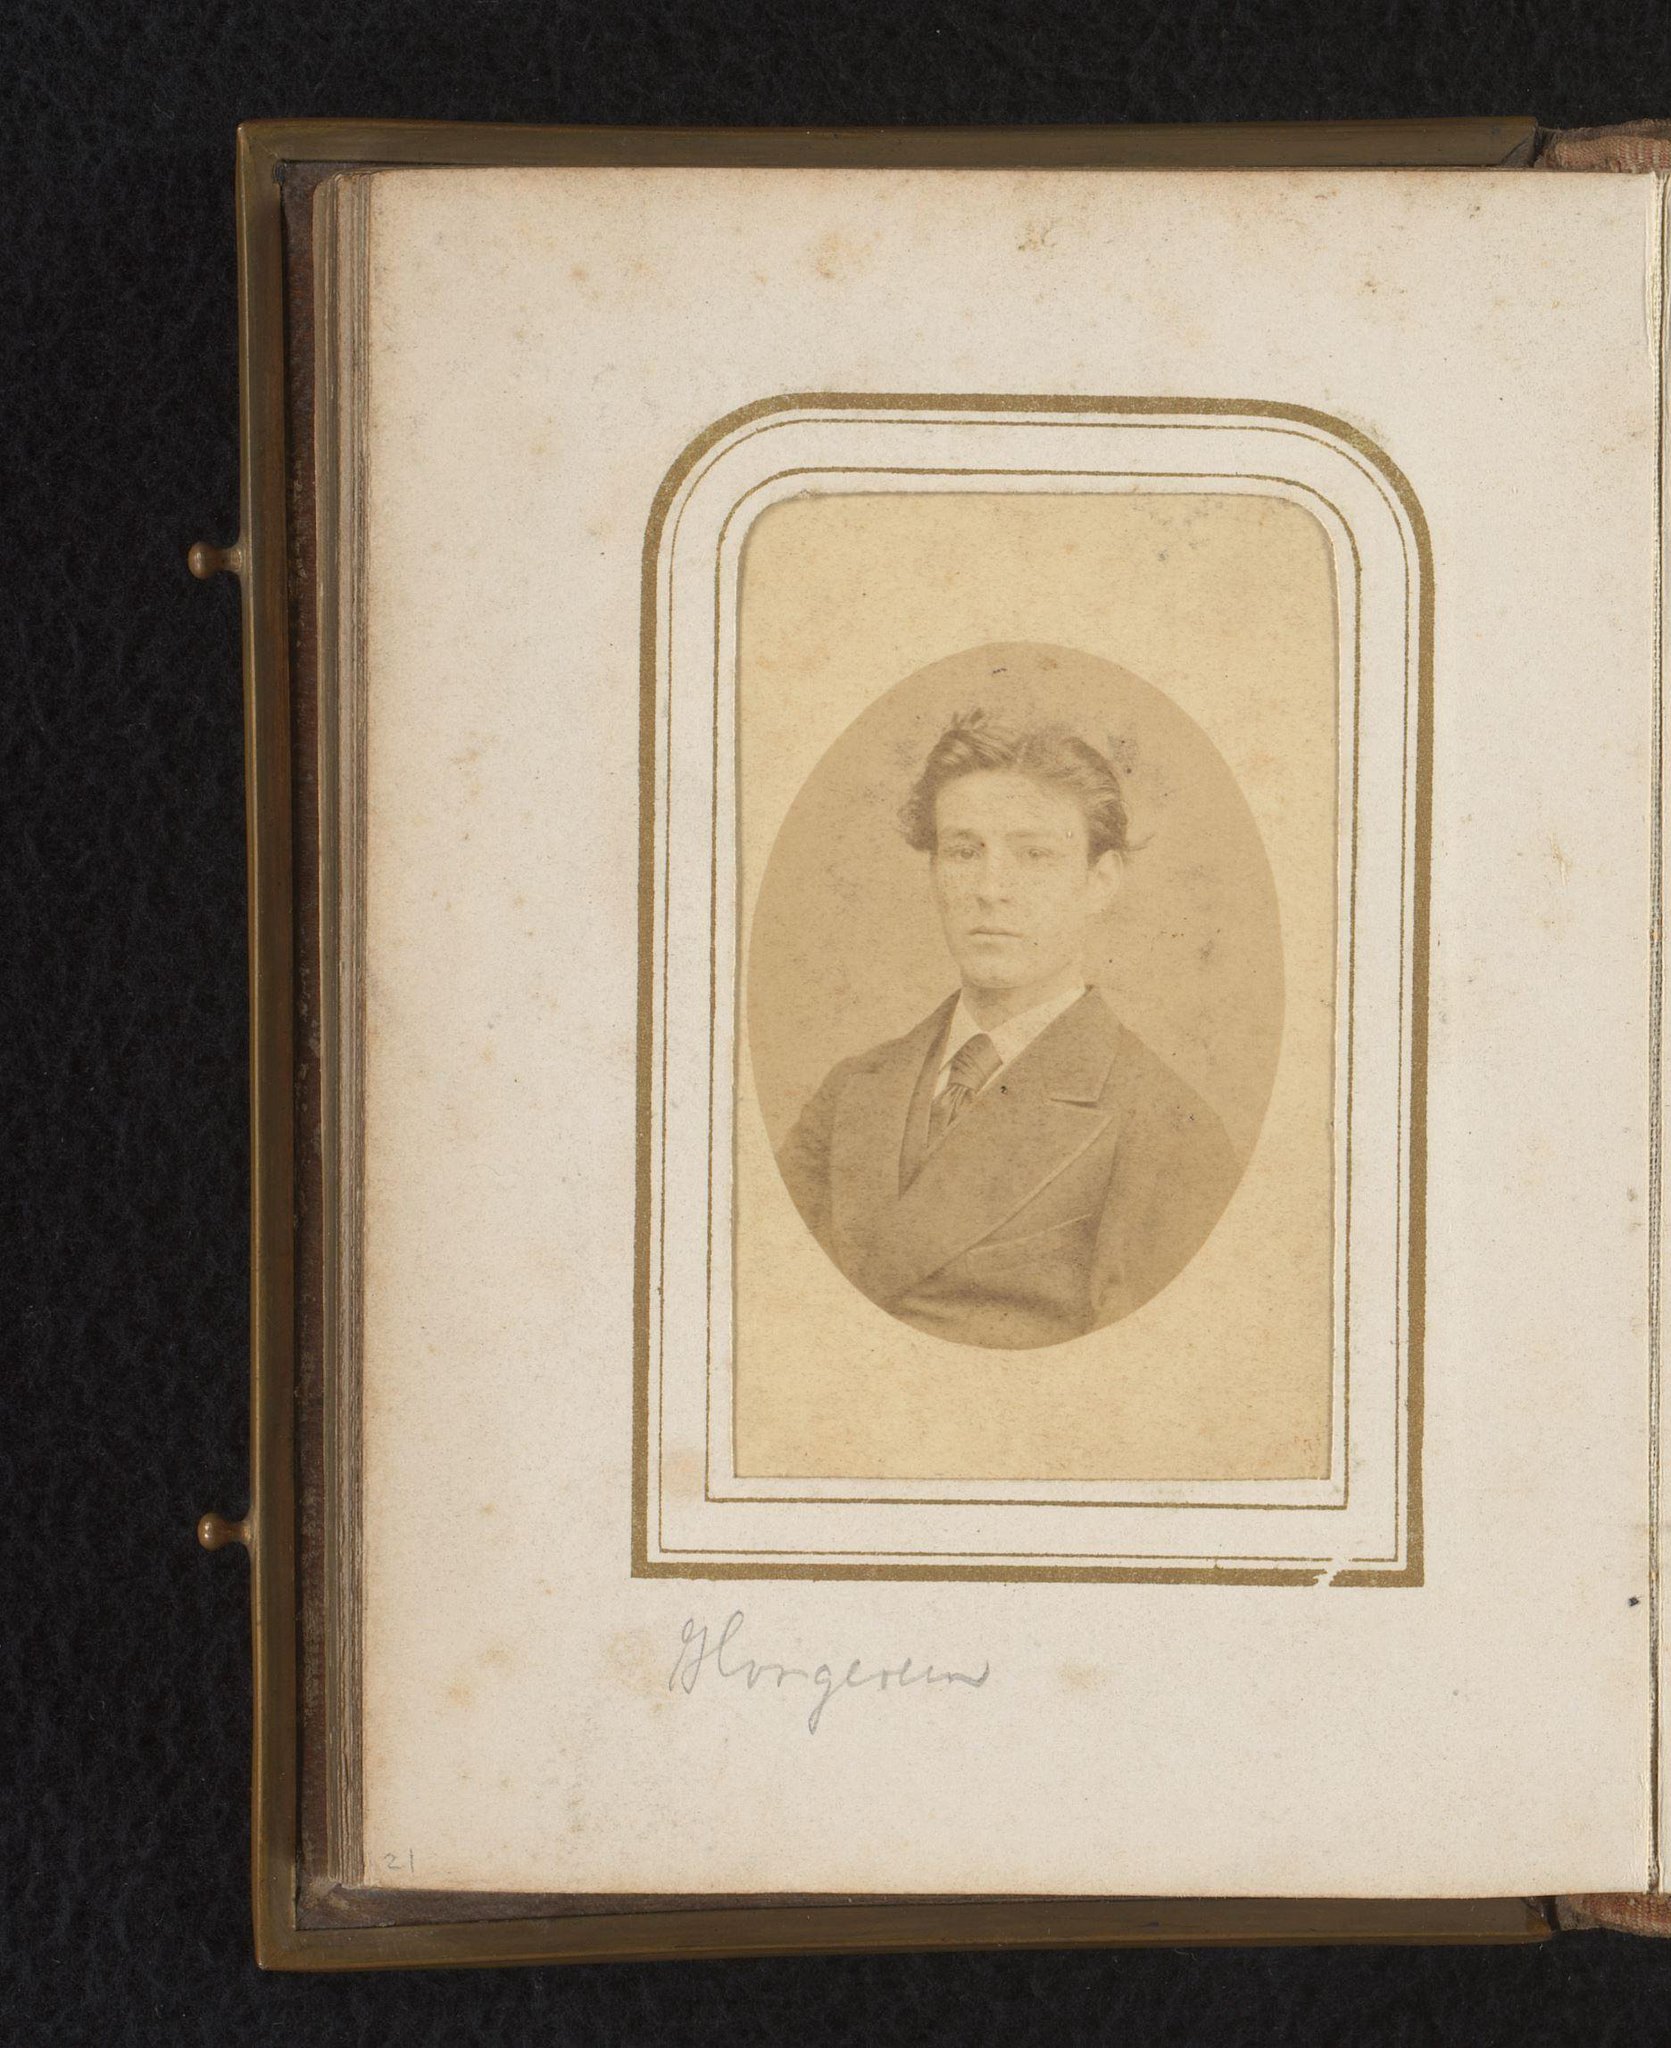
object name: photograph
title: Portret van een man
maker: Anonymous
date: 1860-1900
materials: cardboard, photographic support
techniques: albumen print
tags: adult man, historical persons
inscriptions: annotation: ‘Hoogeveen’, annotation: ‘Hoogeveen’